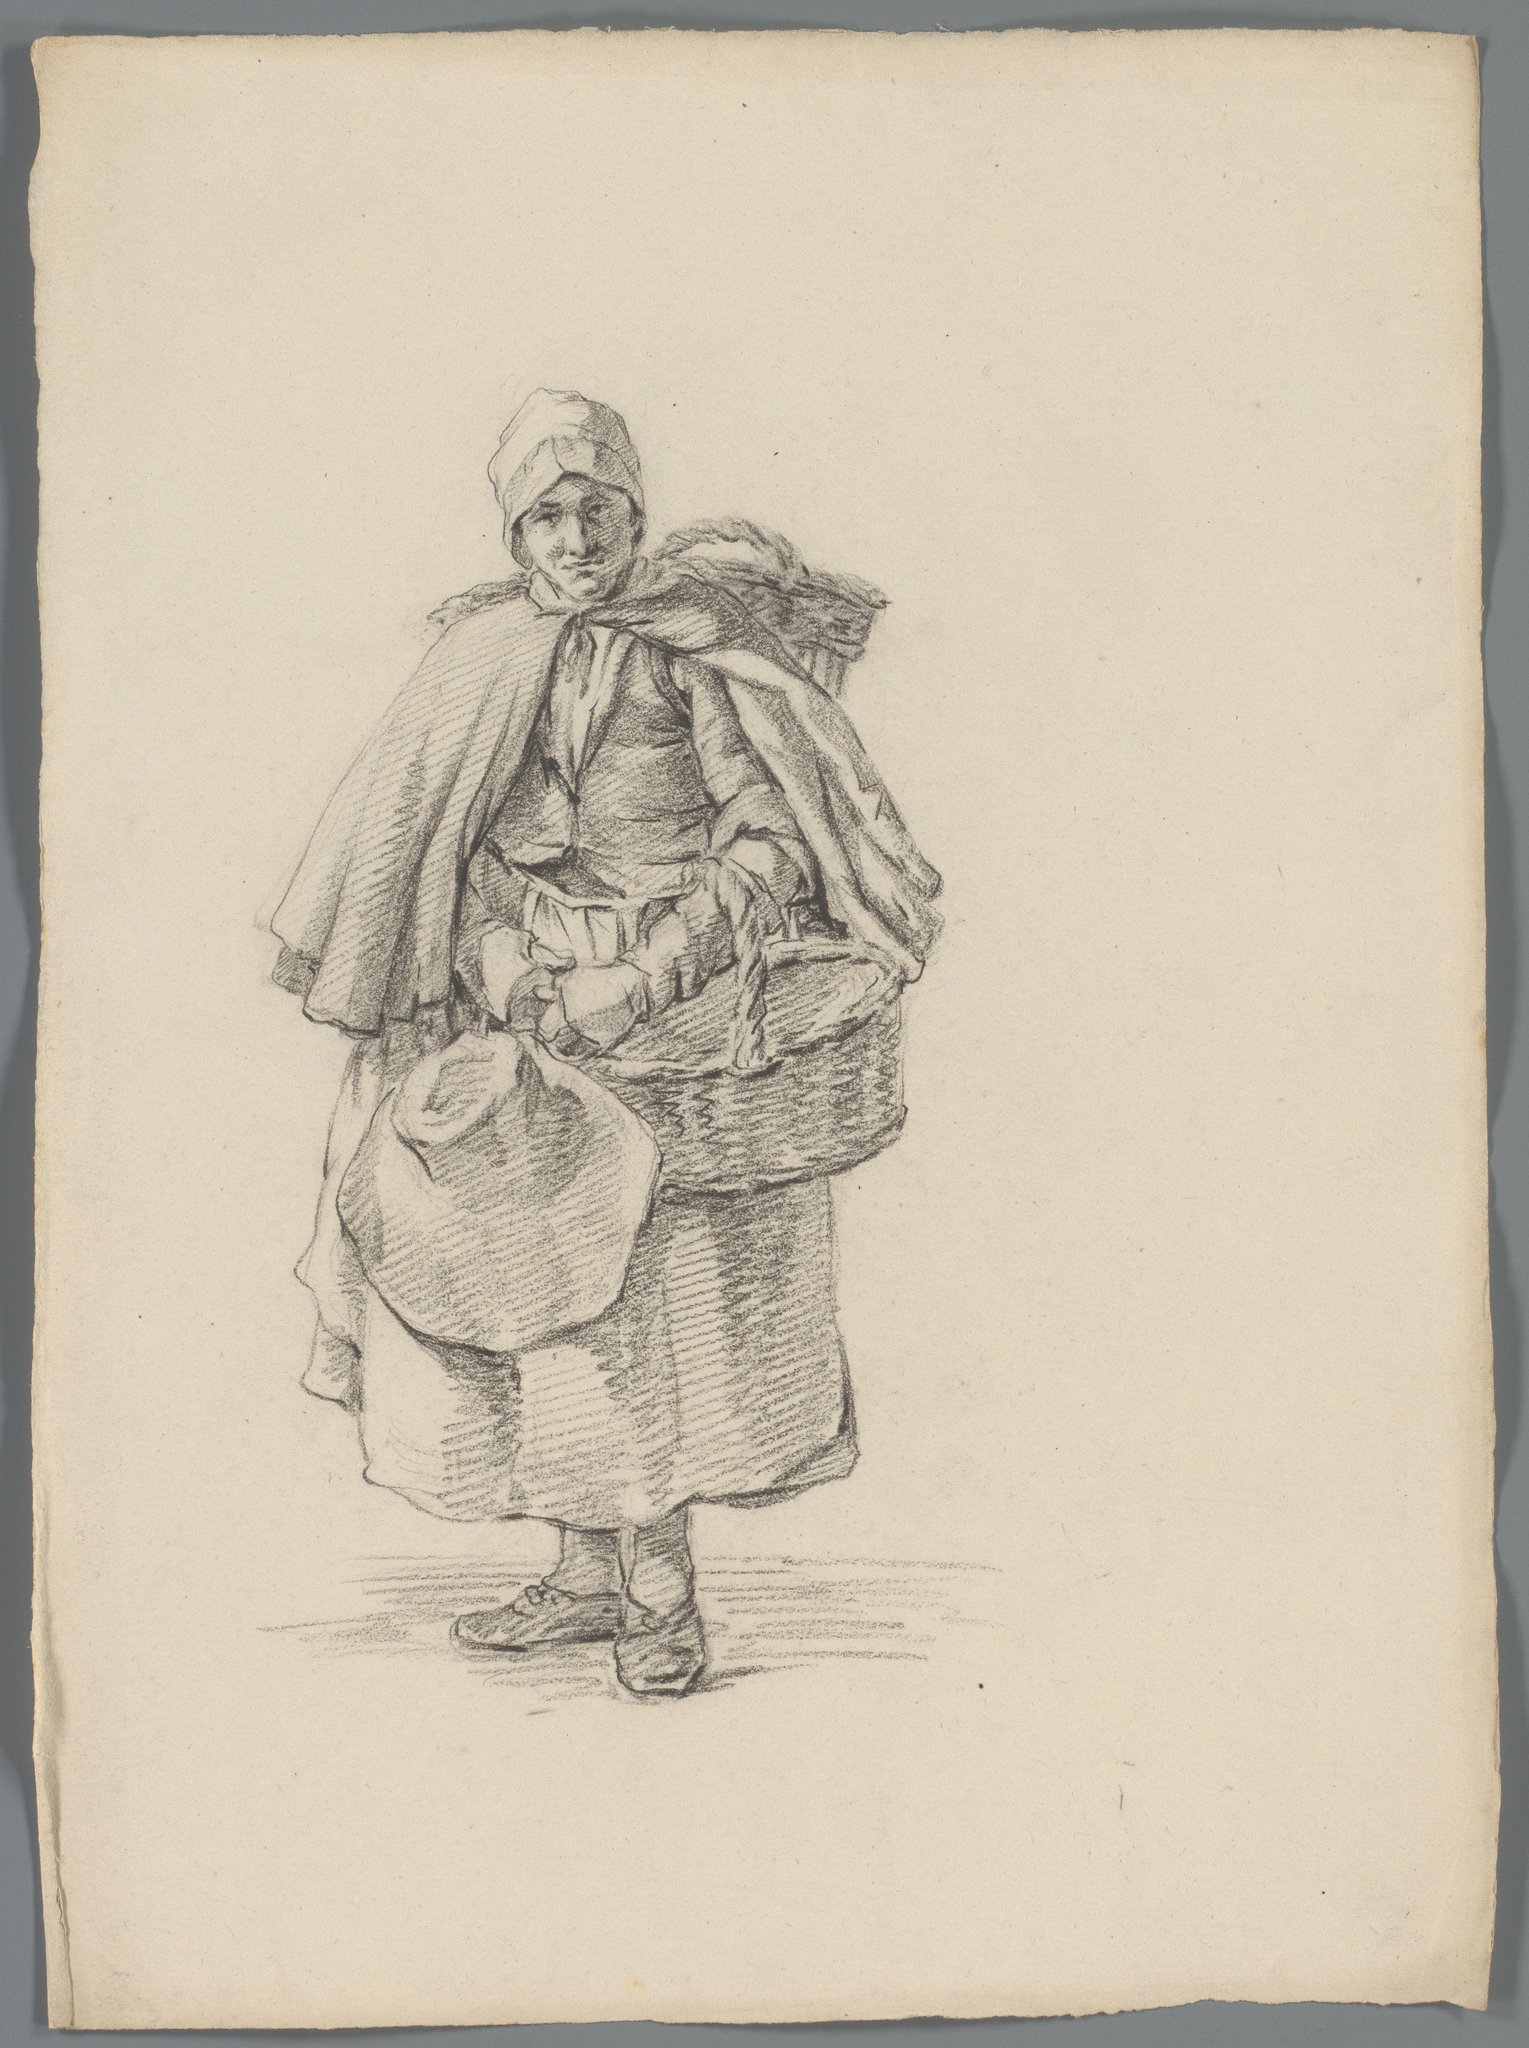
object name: drawing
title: Vrouw met manden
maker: Anonymous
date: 1820-1830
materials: chalk, paper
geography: the hague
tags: adult woman, container made of plant material other than wood: basket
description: Tekeningen waarschijnlijk ontstaan bij het Haagse kunstgenootschap ‘Tot Nut der Tekenkunst’, waar twee keer per week tekenavonden werden georganiseerd met geklede modellen.